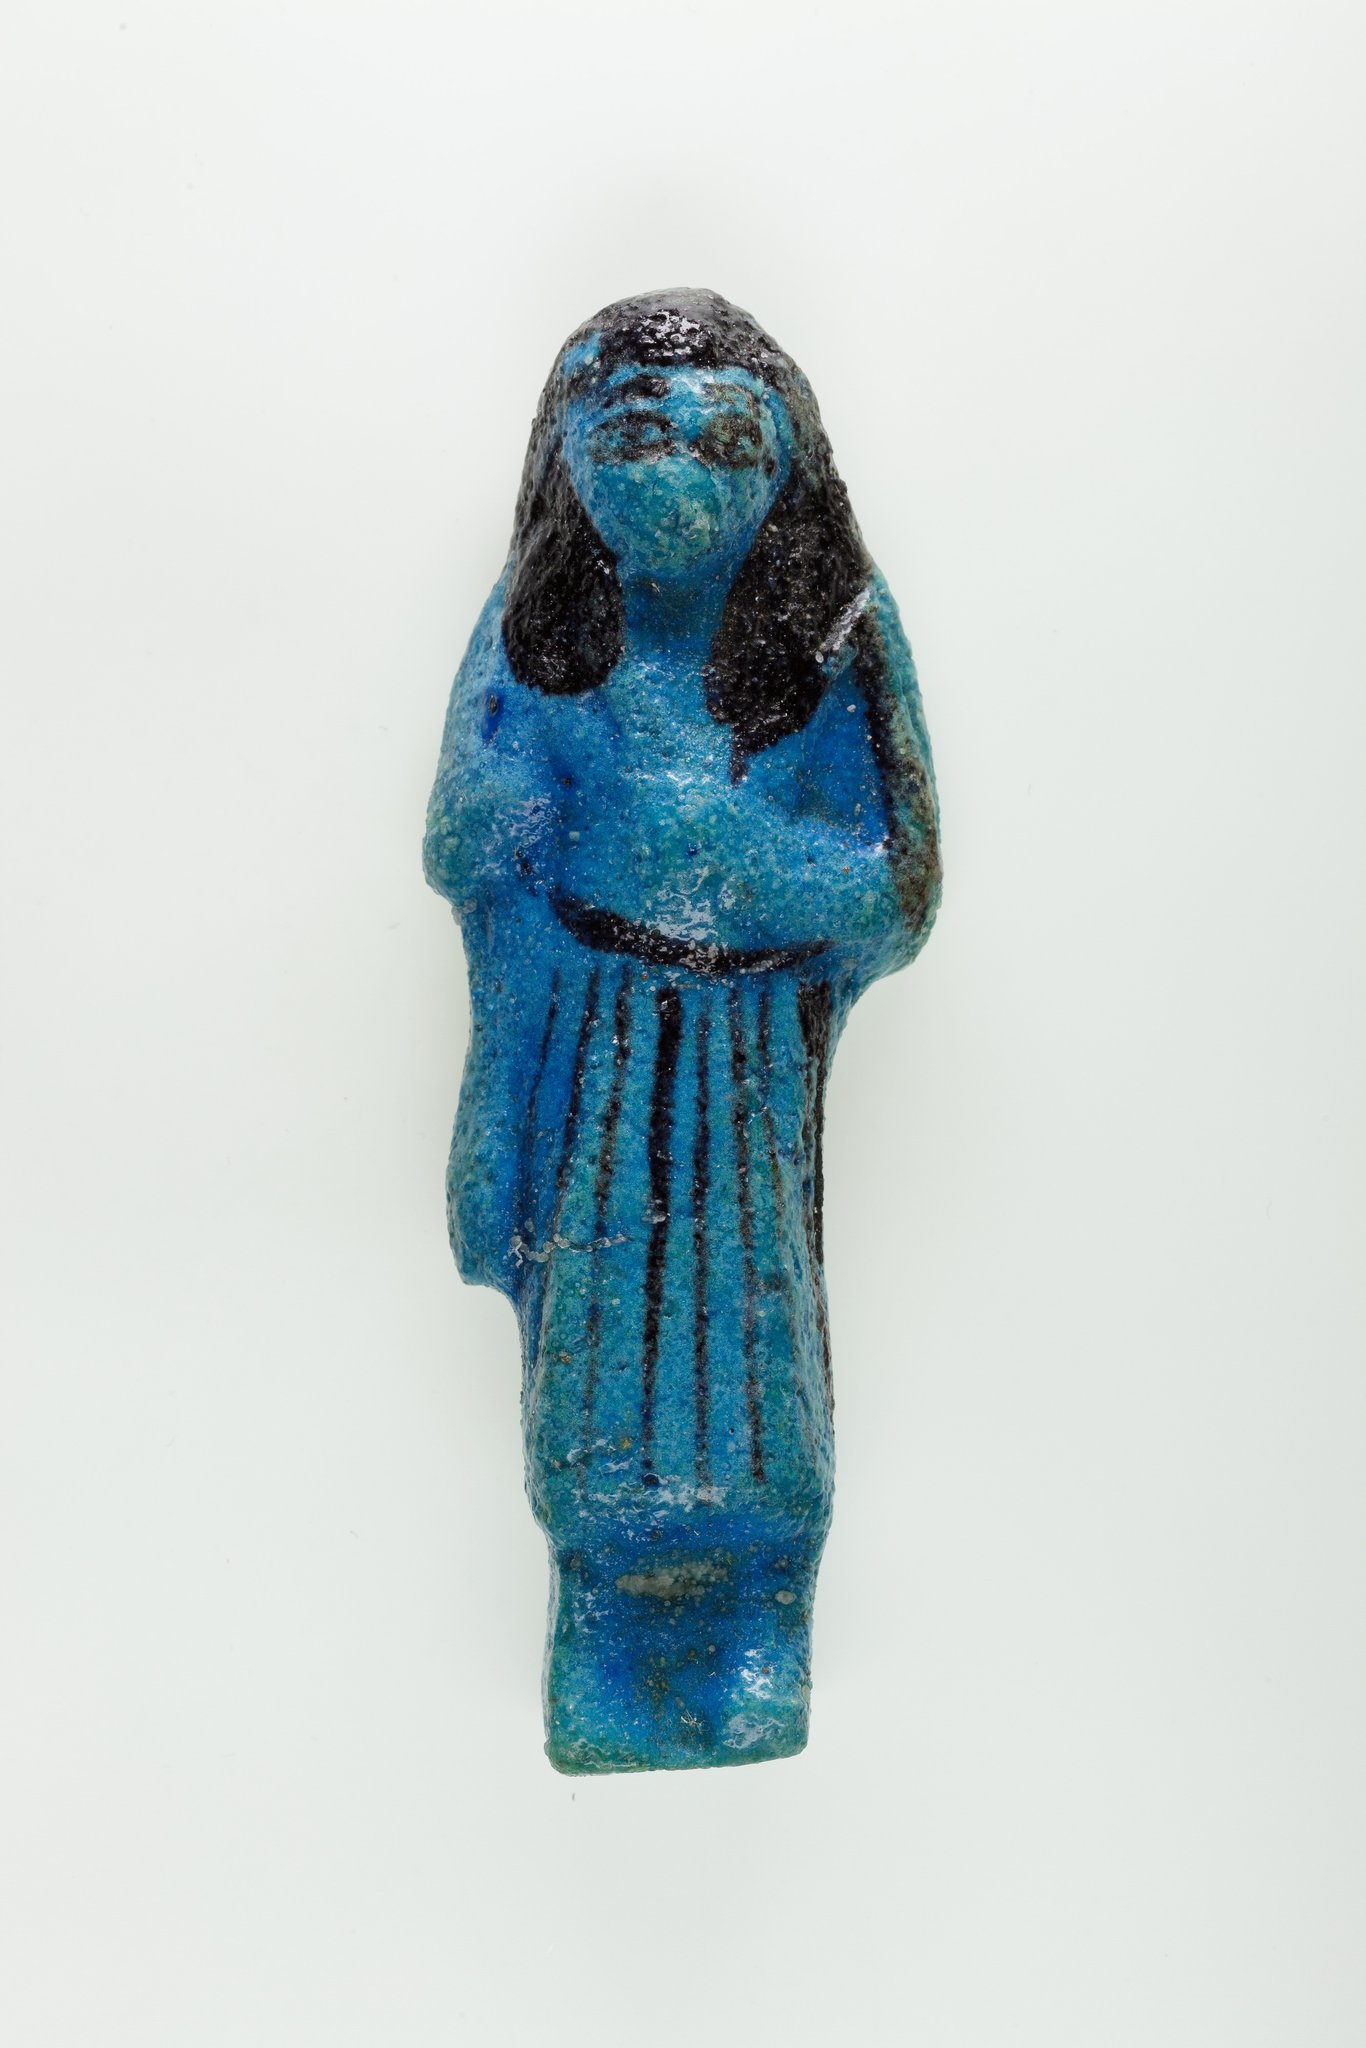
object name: shabti, overseer, nauny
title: Overseer Shabti of Nauny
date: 1050 BCE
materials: faience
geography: egypt